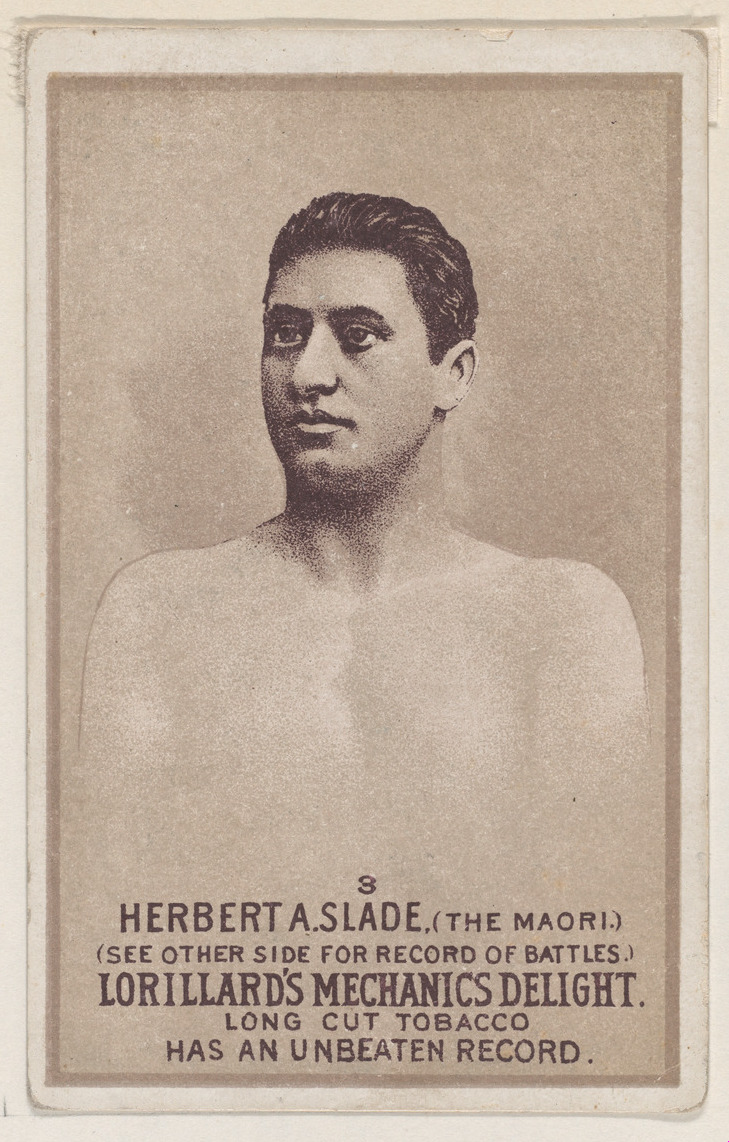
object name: print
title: Card 3, Herbert A. Slade, The Maori, from the Prizefighters series (N269) issued by P. Lorillard Company to promote Mechanics Delight Long Cut Tobacco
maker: p. lorillard company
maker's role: publisher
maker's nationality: american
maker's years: 1760-2014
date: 1887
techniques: color lithograph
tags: men,portraits,boxing,athletes